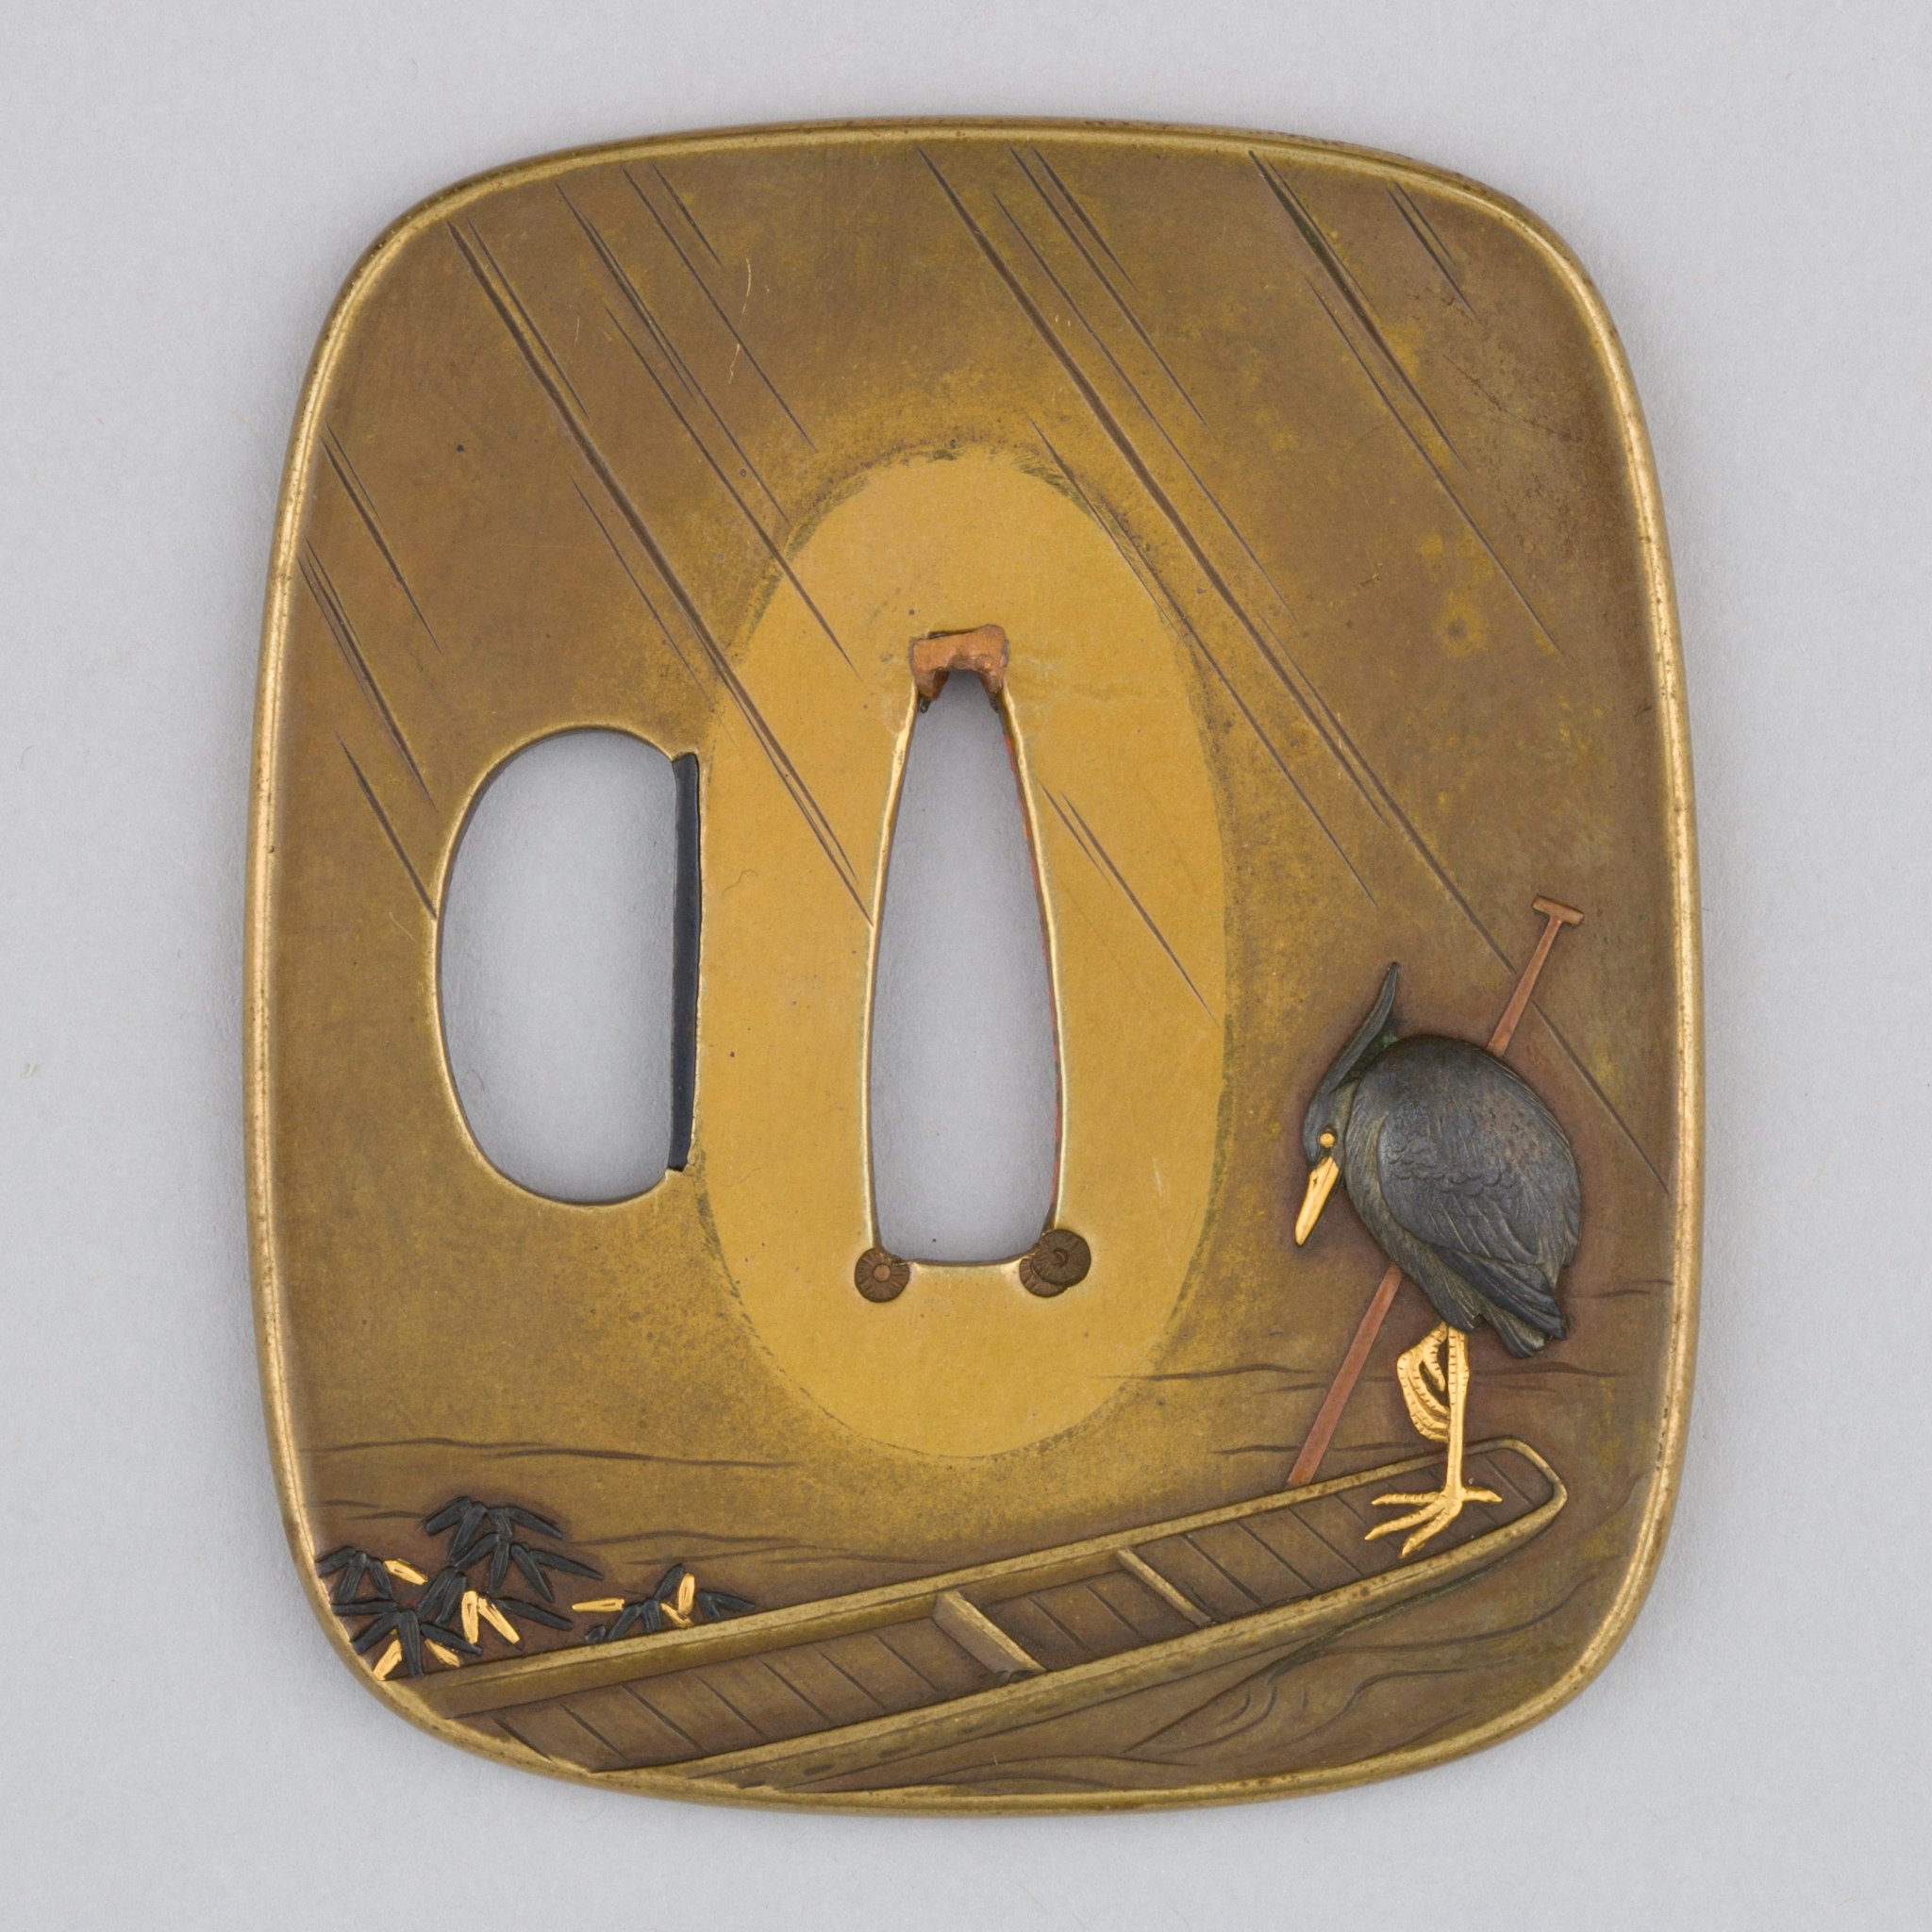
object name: sword guard tsuba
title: Sword Guard (Tsuba)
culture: japanese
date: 1615-1868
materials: copper, copper alloy, gold alloy, silver alloy, gold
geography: japan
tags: birds